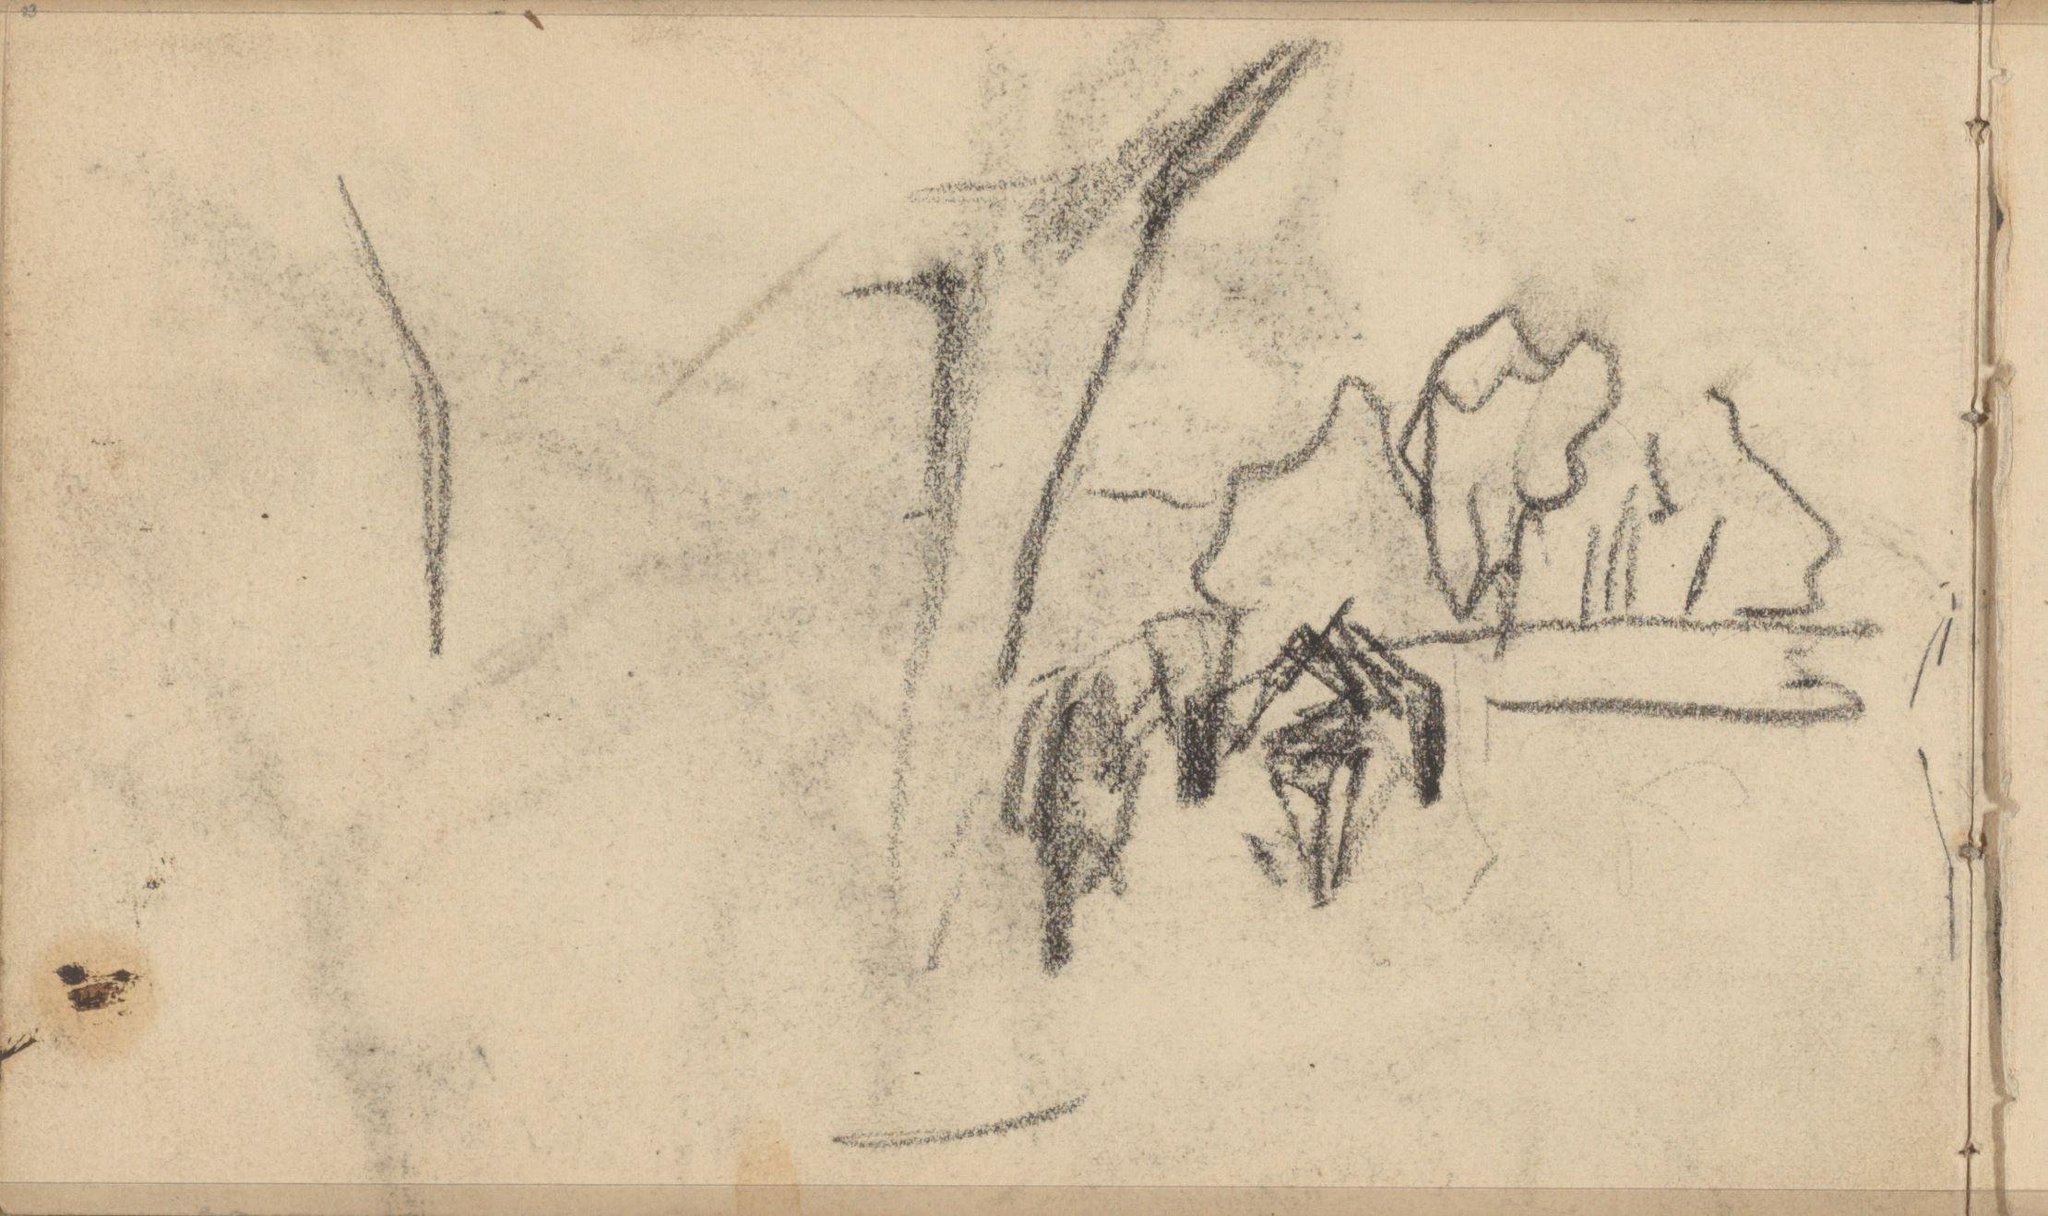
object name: sketchbook leaf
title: Studie, mogelijk van een landschap met paarden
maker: george hendrik breitner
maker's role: draughtsman, painter, print maker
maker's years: 1857-1923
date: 1884-1886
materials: chalk, paper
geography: the hague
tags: landscapes, horse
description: Pagina 23 uit een schetsboek met 35 bladen.